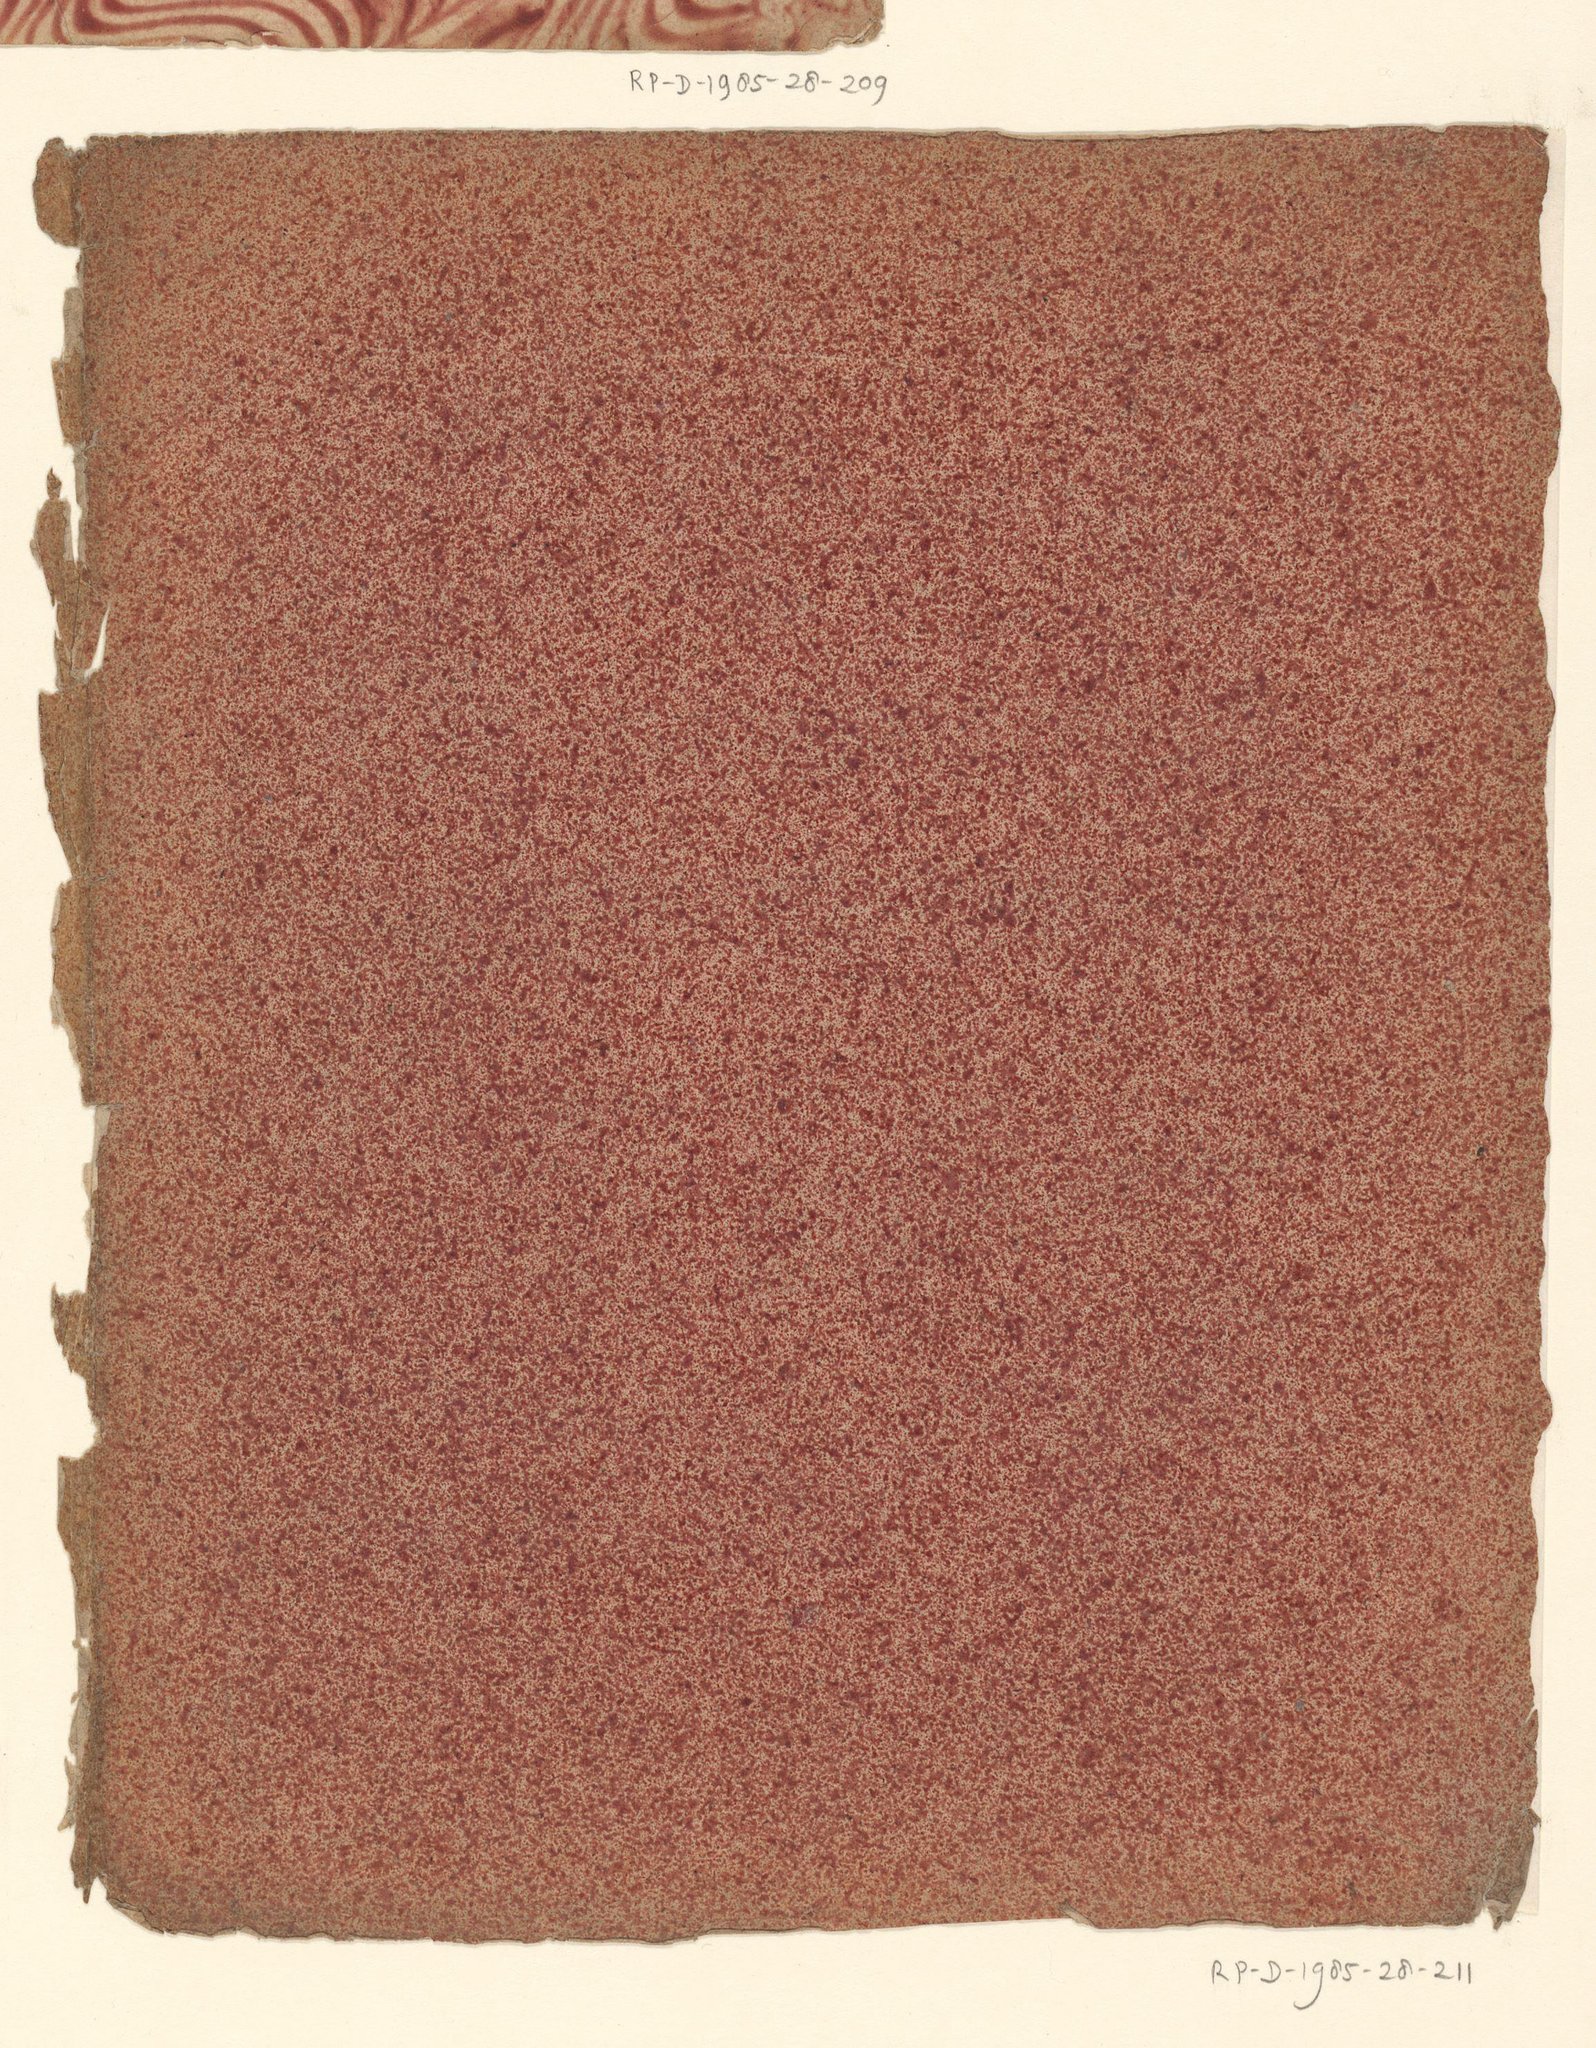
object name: wrapper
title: Rood gespikkeld papier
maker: Anonymous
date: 1750-1900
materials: paper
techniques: splatter marble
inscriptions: collector's mark: Lugt 2760, collector's mark: Lugt 2228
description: Rood gespikkeld papier. Helft van een omslag.